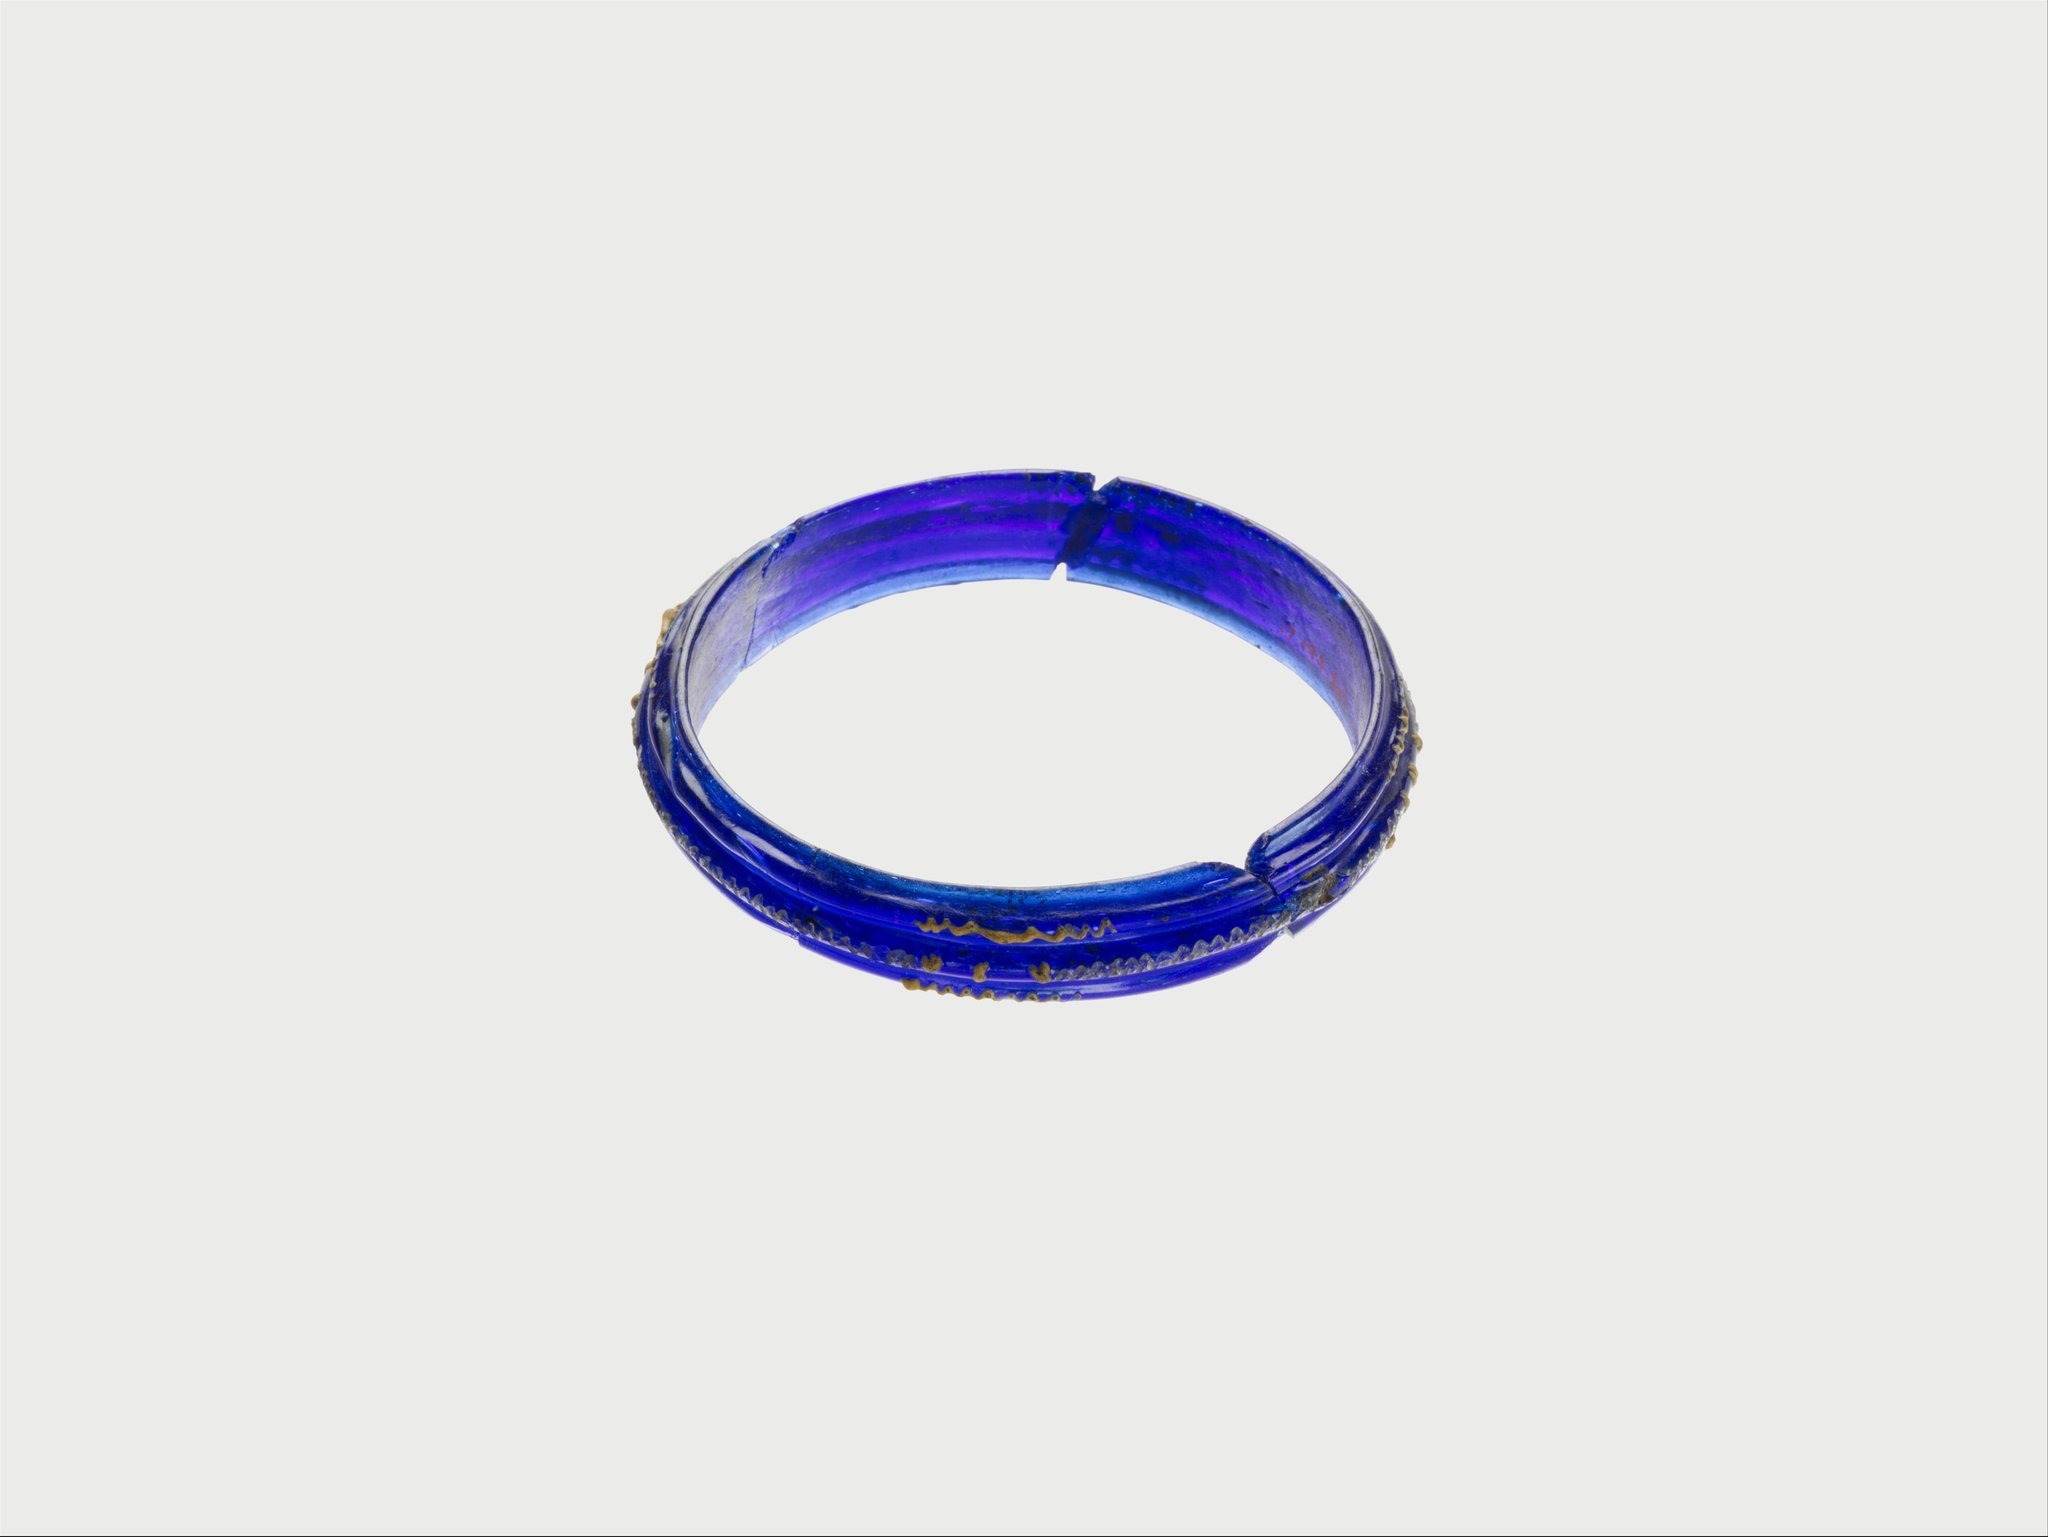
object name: bracelet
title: Glass bracelet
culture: celtic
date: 234-101 BCE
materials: glass